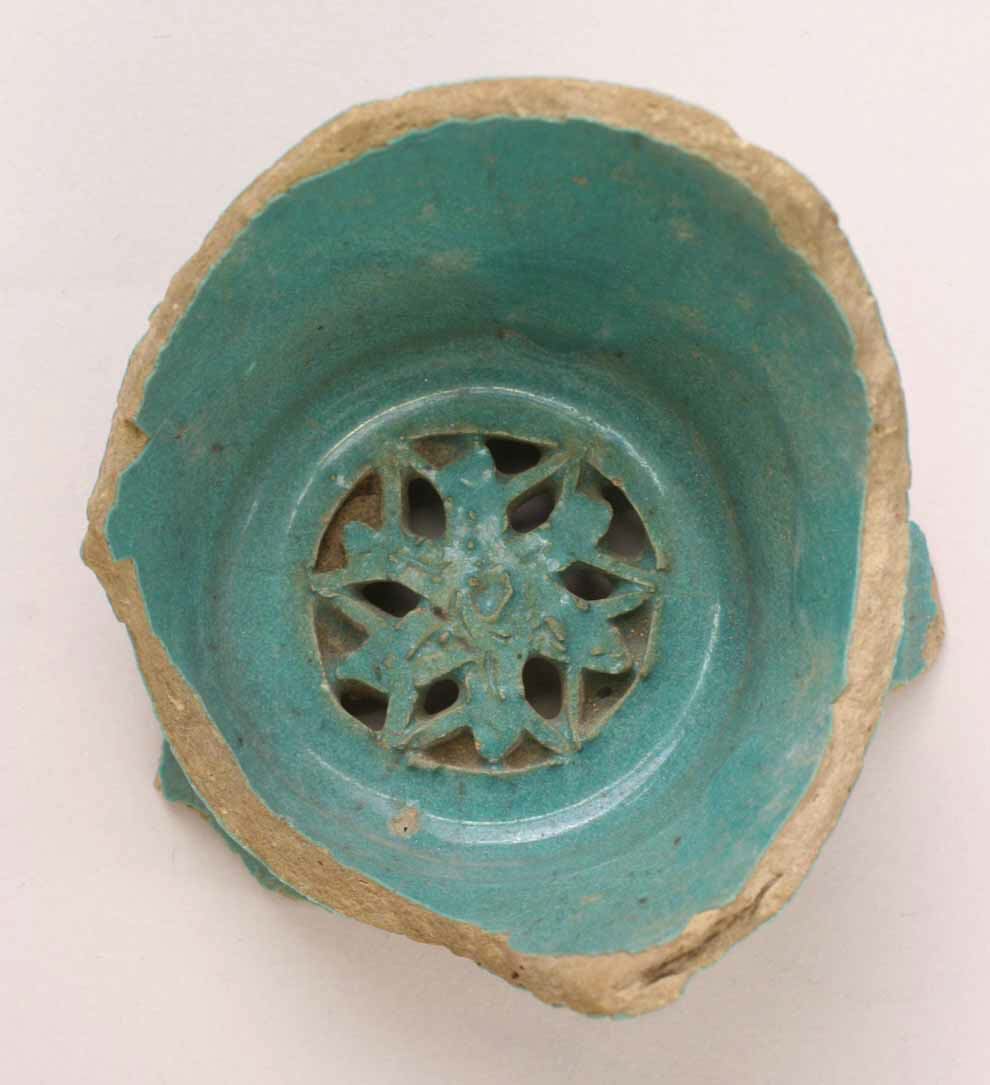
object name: water filter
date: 901-1200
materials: stonepaste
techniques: glazing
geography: egypt